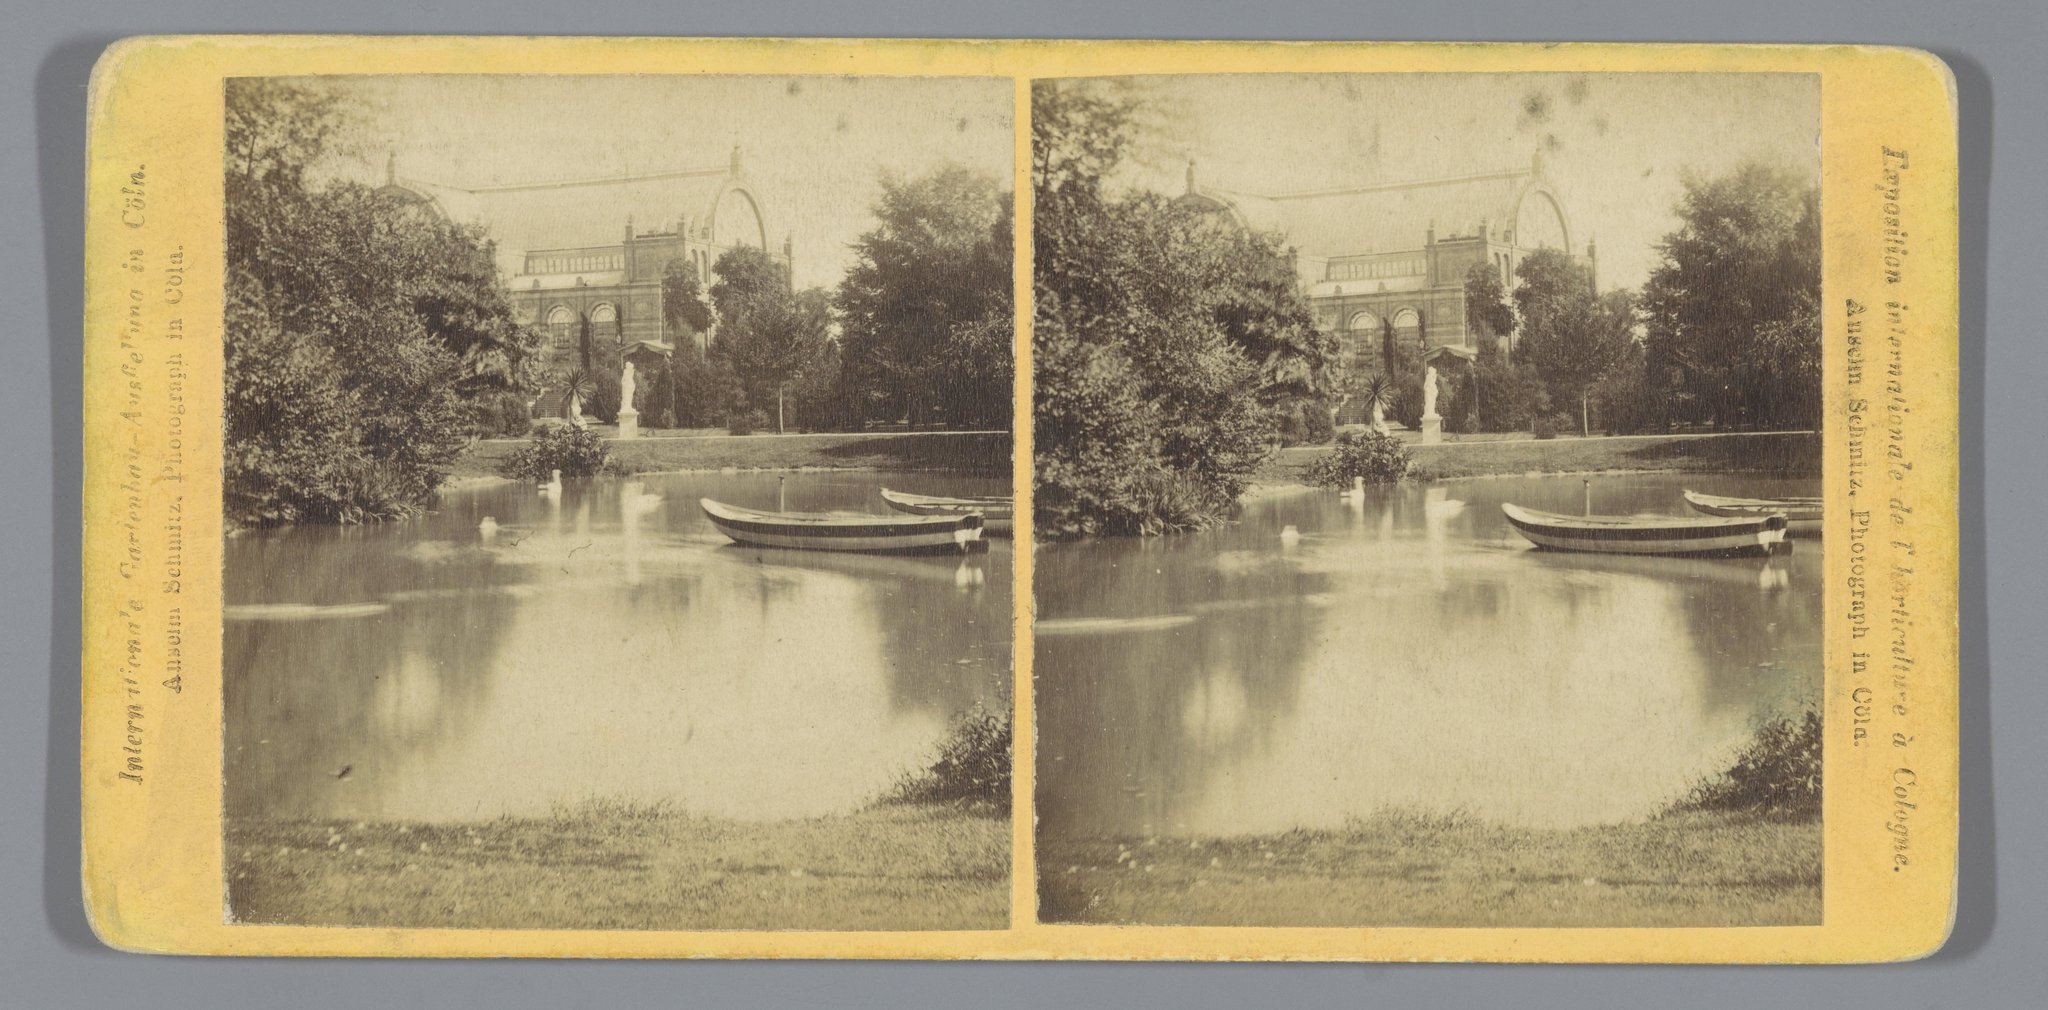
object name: stereograph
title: Internationale Gartenbau-Ausstellung zu Cöln / Exposition internationale de l'horticulture à Cologne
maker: anselm schmitz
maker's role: publisher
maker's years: 1831-1903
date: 1875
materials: cardboard, paper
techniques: albumen print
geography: cologne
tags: botanic garden, 'hortus botanicus', garden pond, cologne